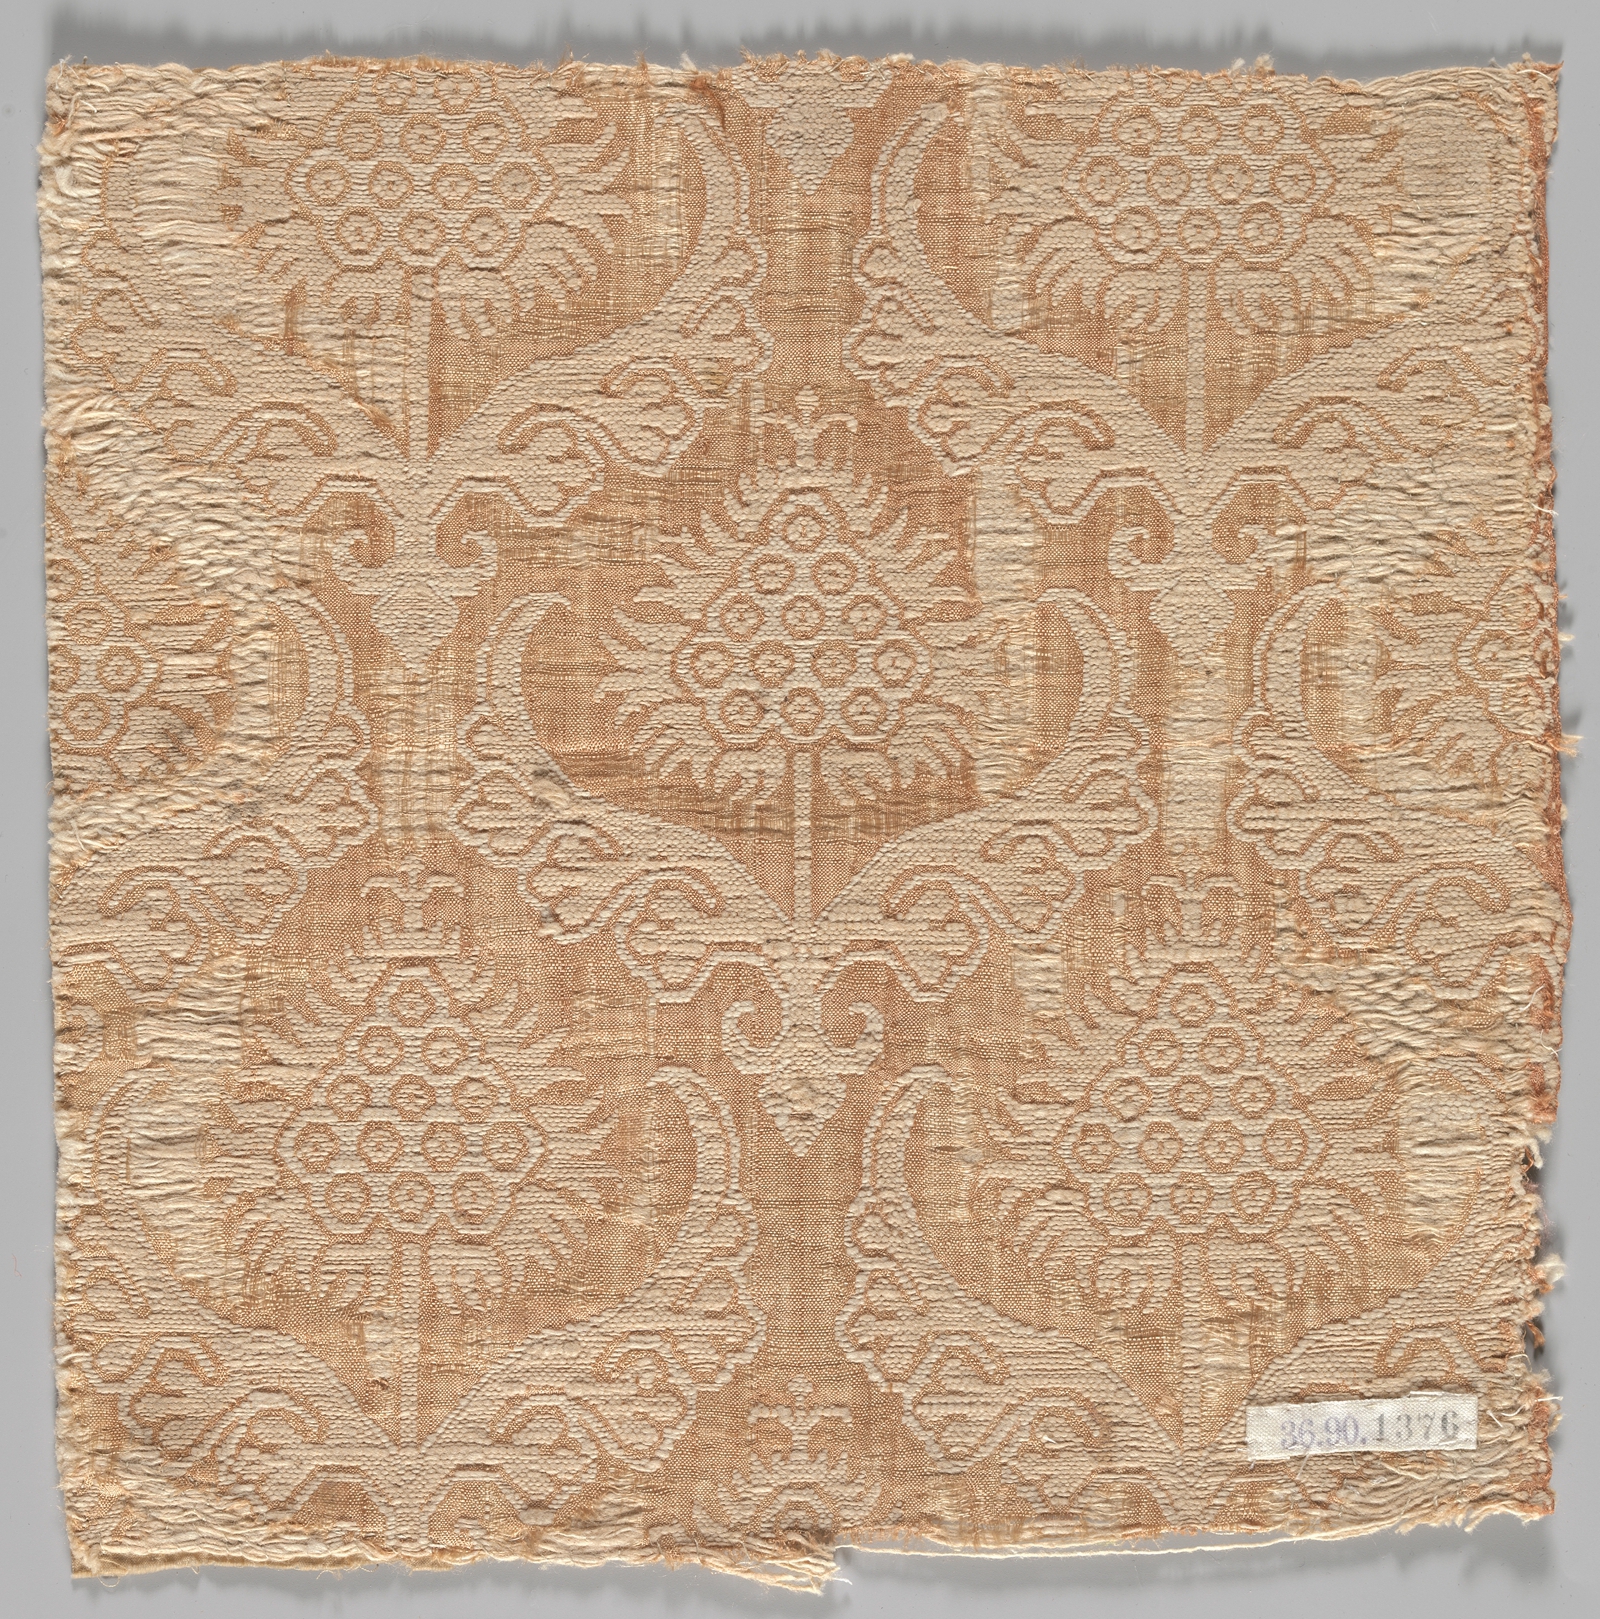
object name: piece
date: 1501-1600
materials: linen, silk